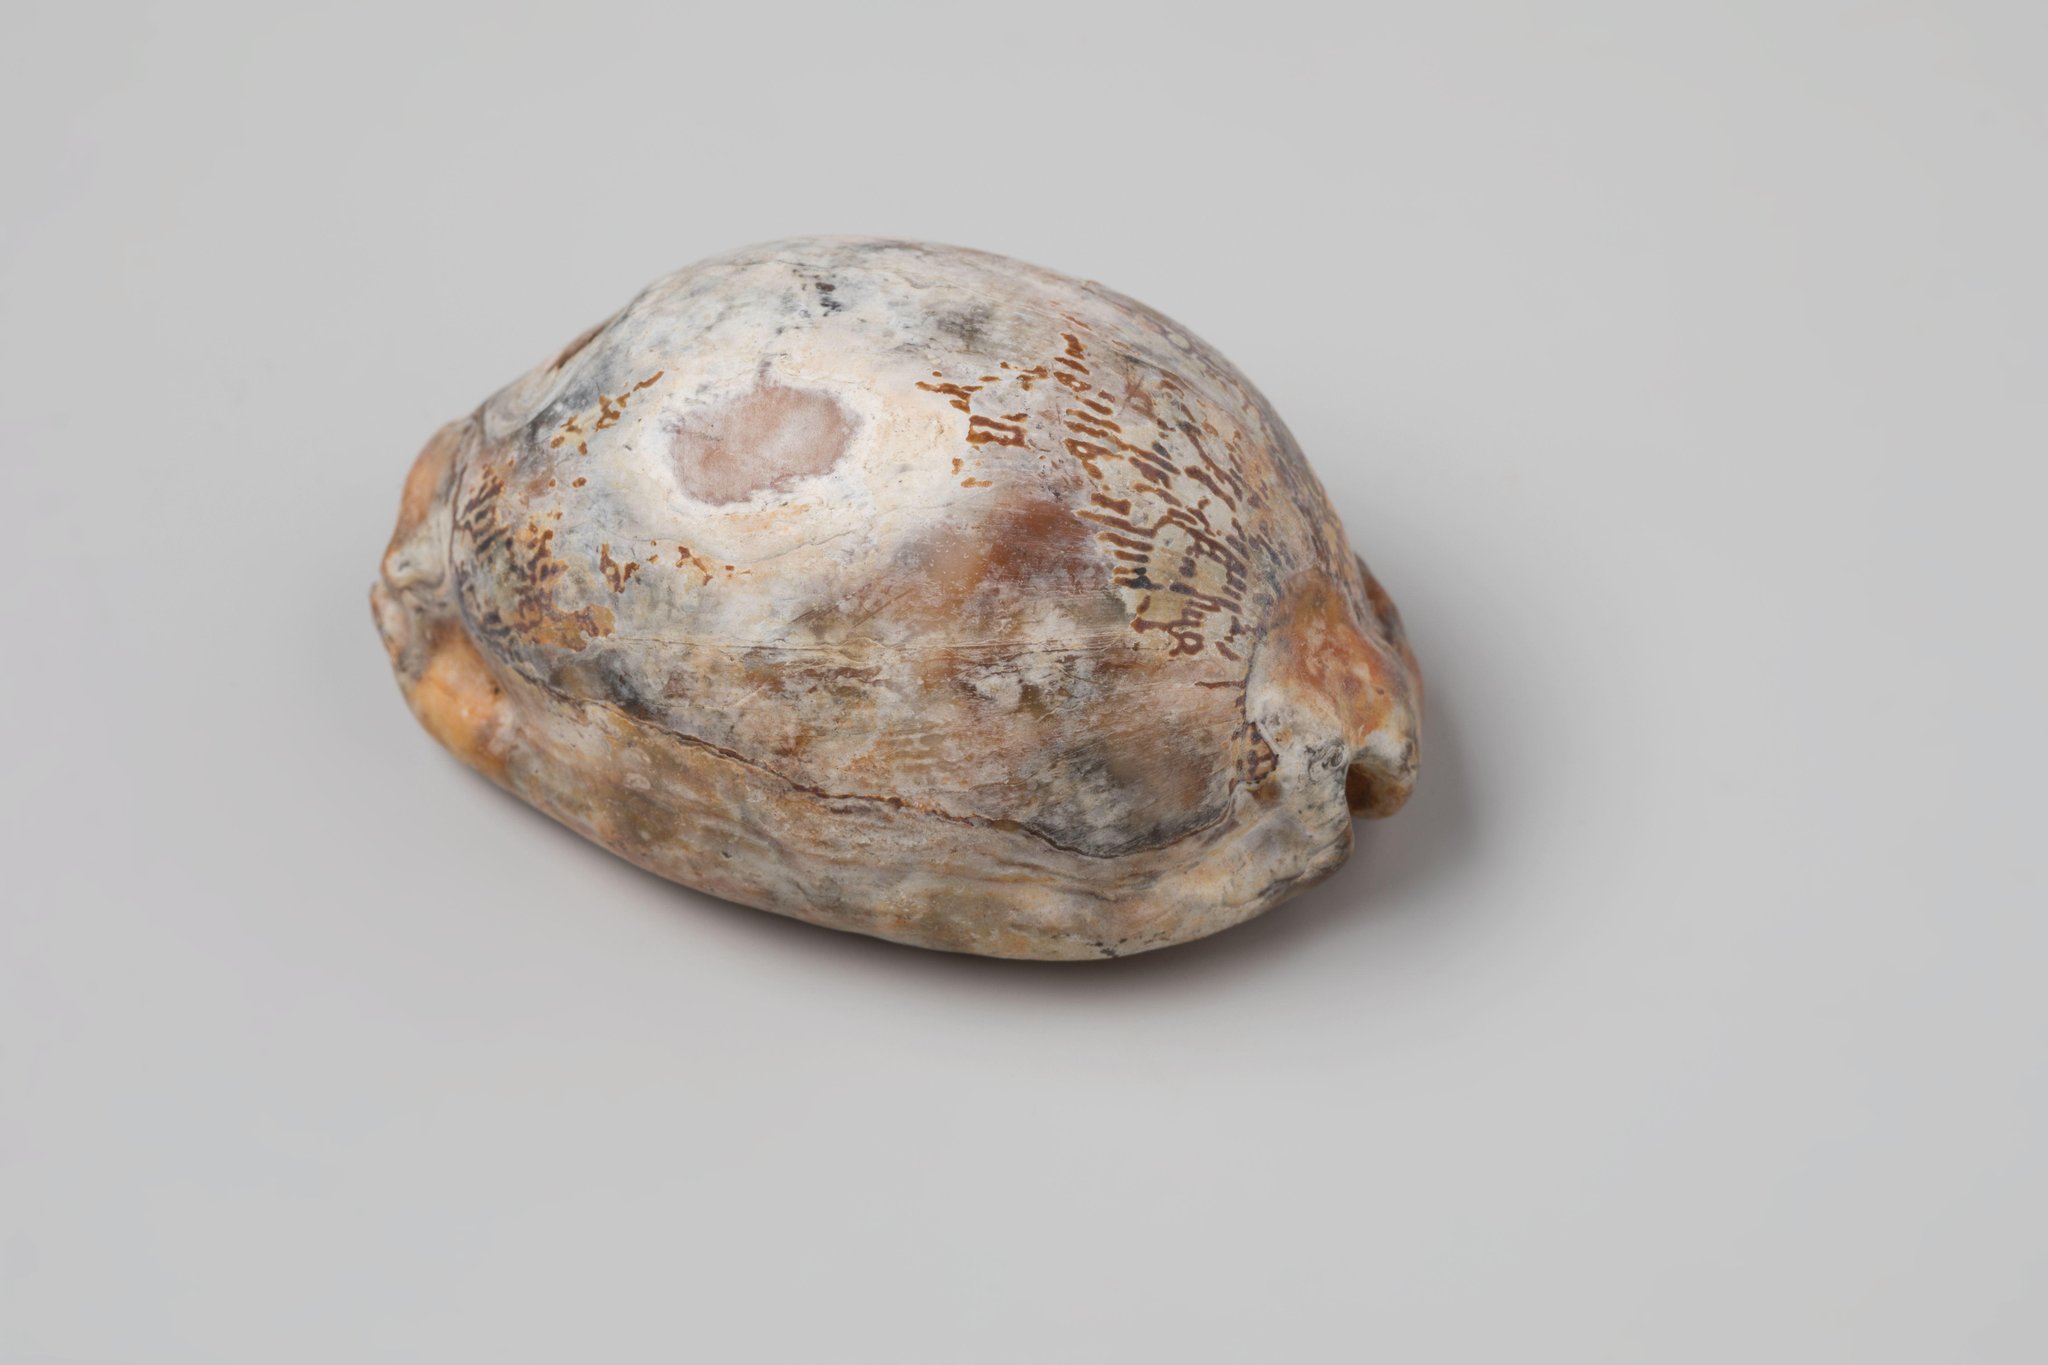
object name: cypraea arabica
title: Cypraea arabica shell from the wreck of the Dutch East India ship Witte Leeuw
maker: niet van toepassing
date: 1613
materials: shell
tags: verenigde oostindische compagnie, sint-helena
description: Schelp uit V.O.C.-schip de 'Witte Leeuw'.